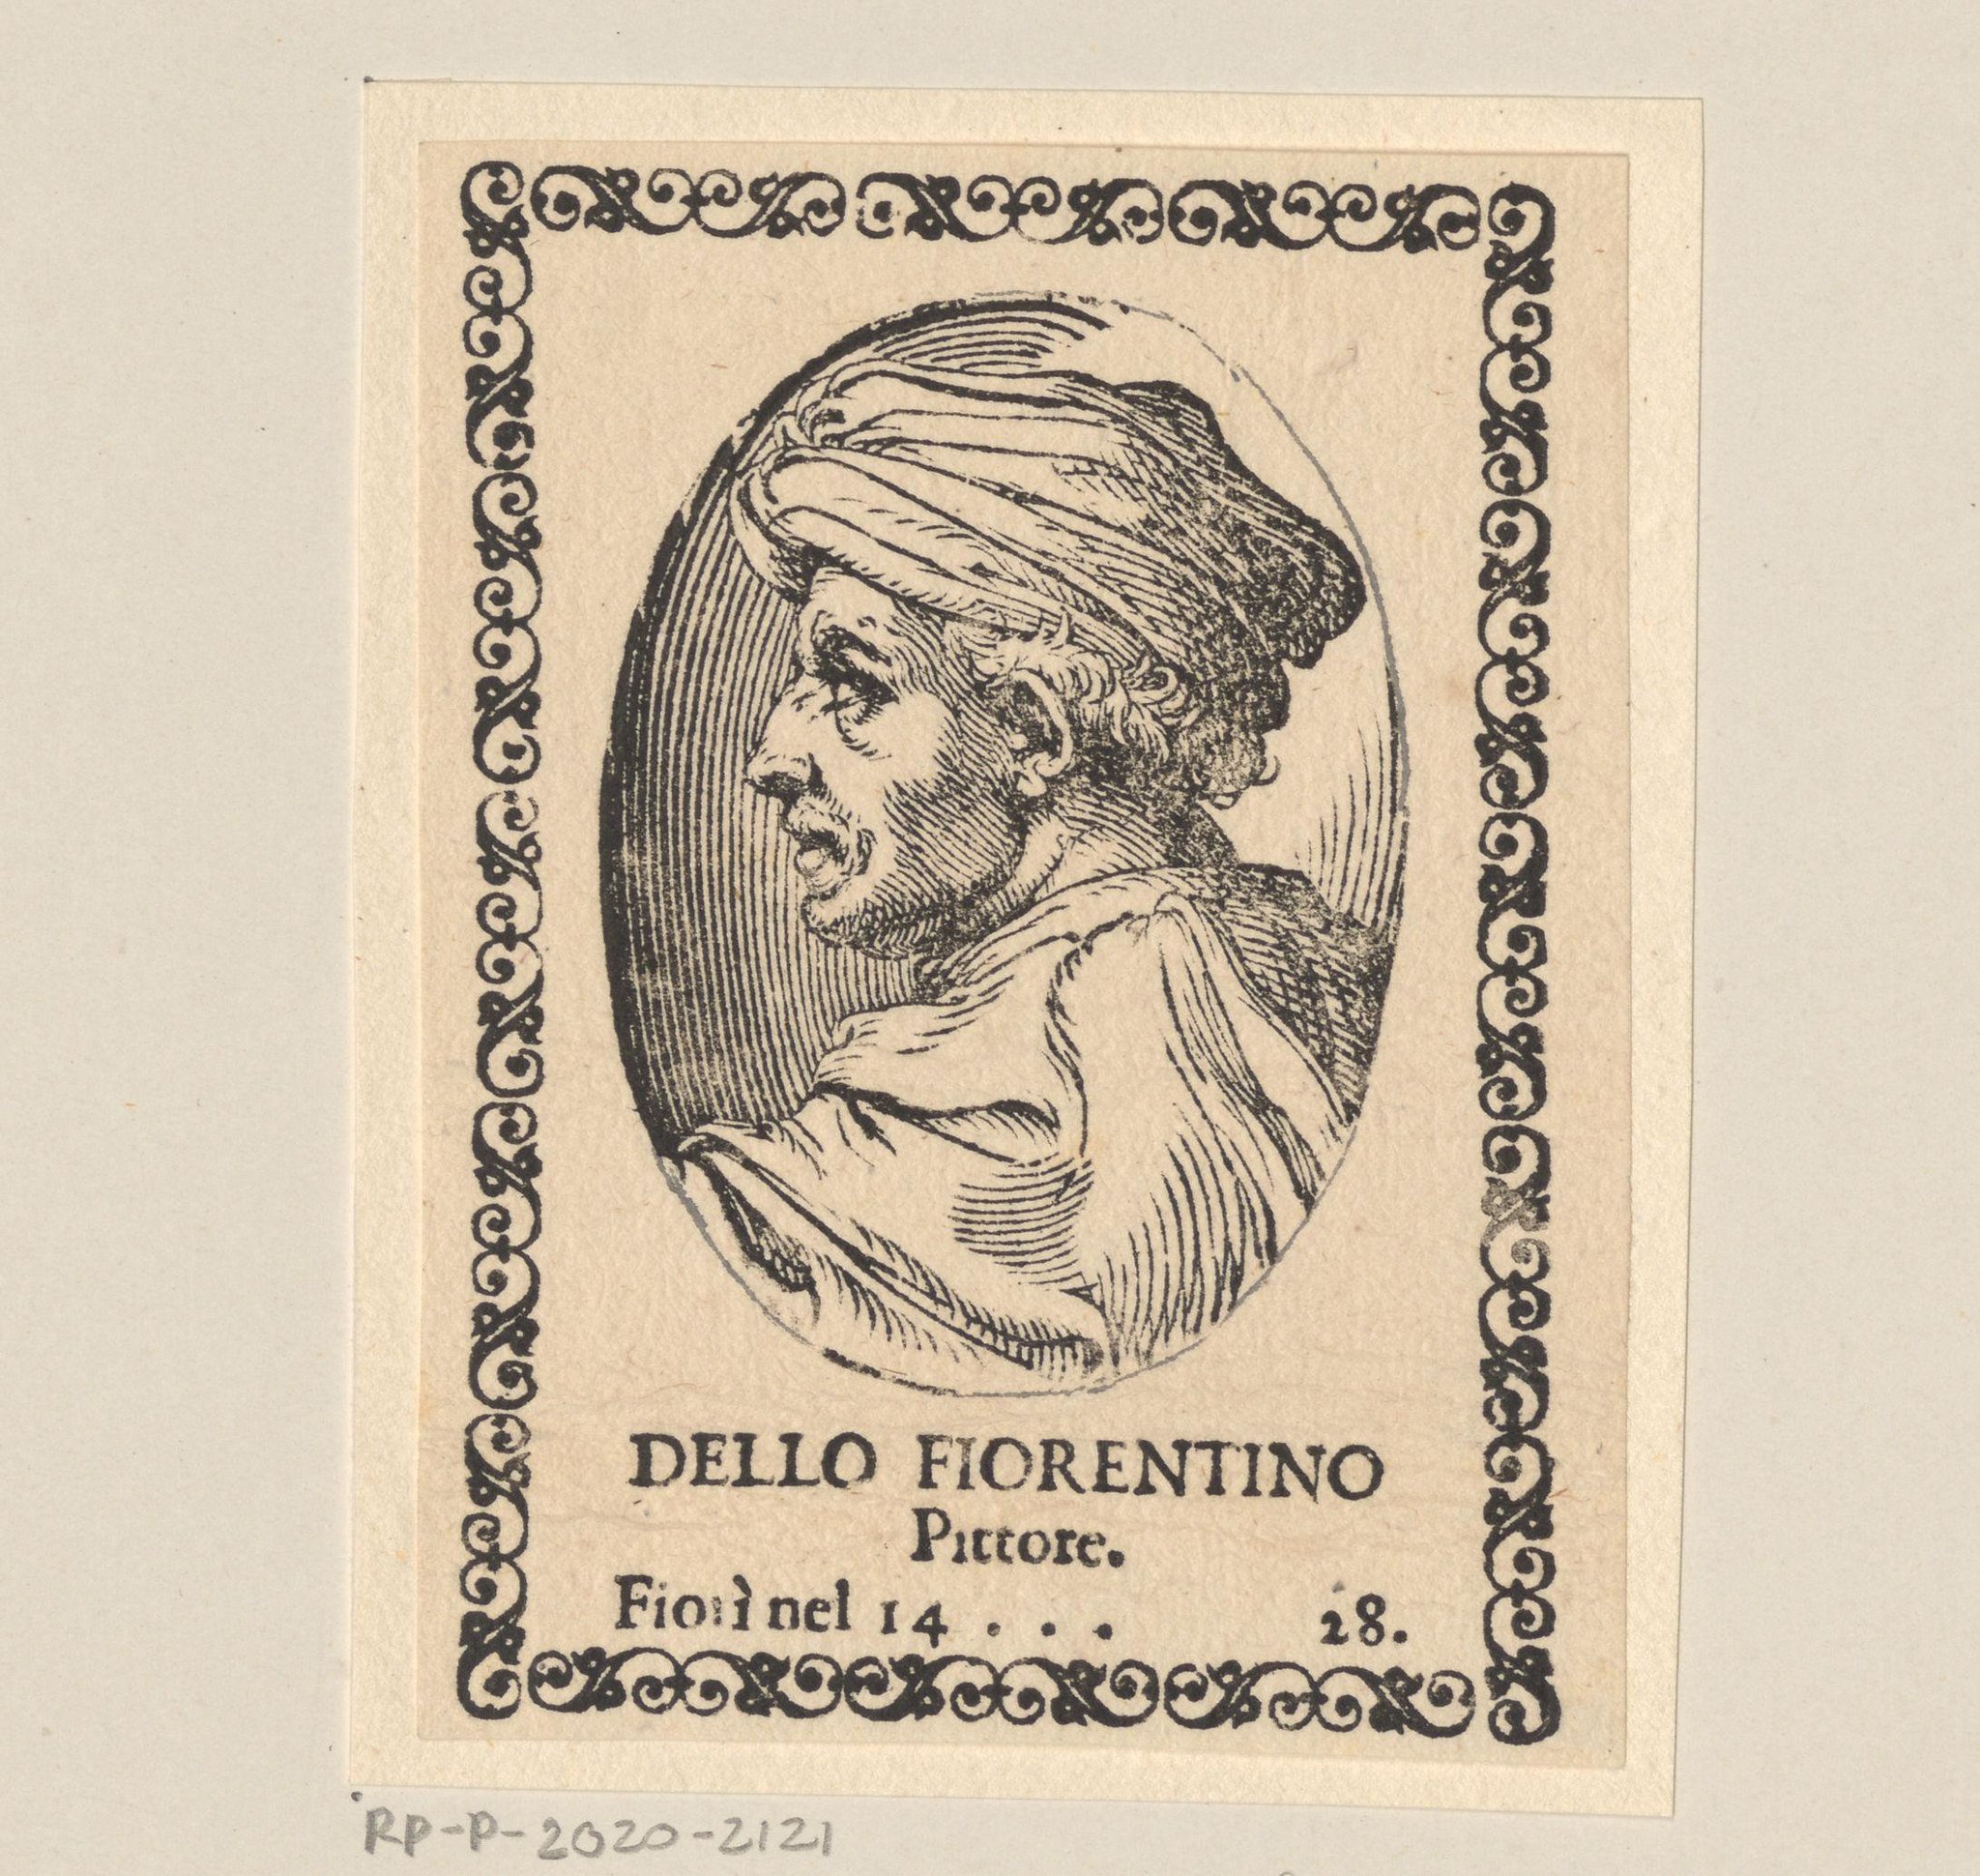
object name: print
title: Portret van Dello di Niccolò Delli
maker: Anonymous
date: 1568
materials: paper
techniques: woodcut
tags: painter, sculptor, historical persons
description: Prent met andere omlijsting gebruikt in: Vasari, Giorgio. Le vite de’ più eccellenti pittori, scultori e architettori. Florence: Bernardo Giunti, 1568, dl. 2, p. 256.